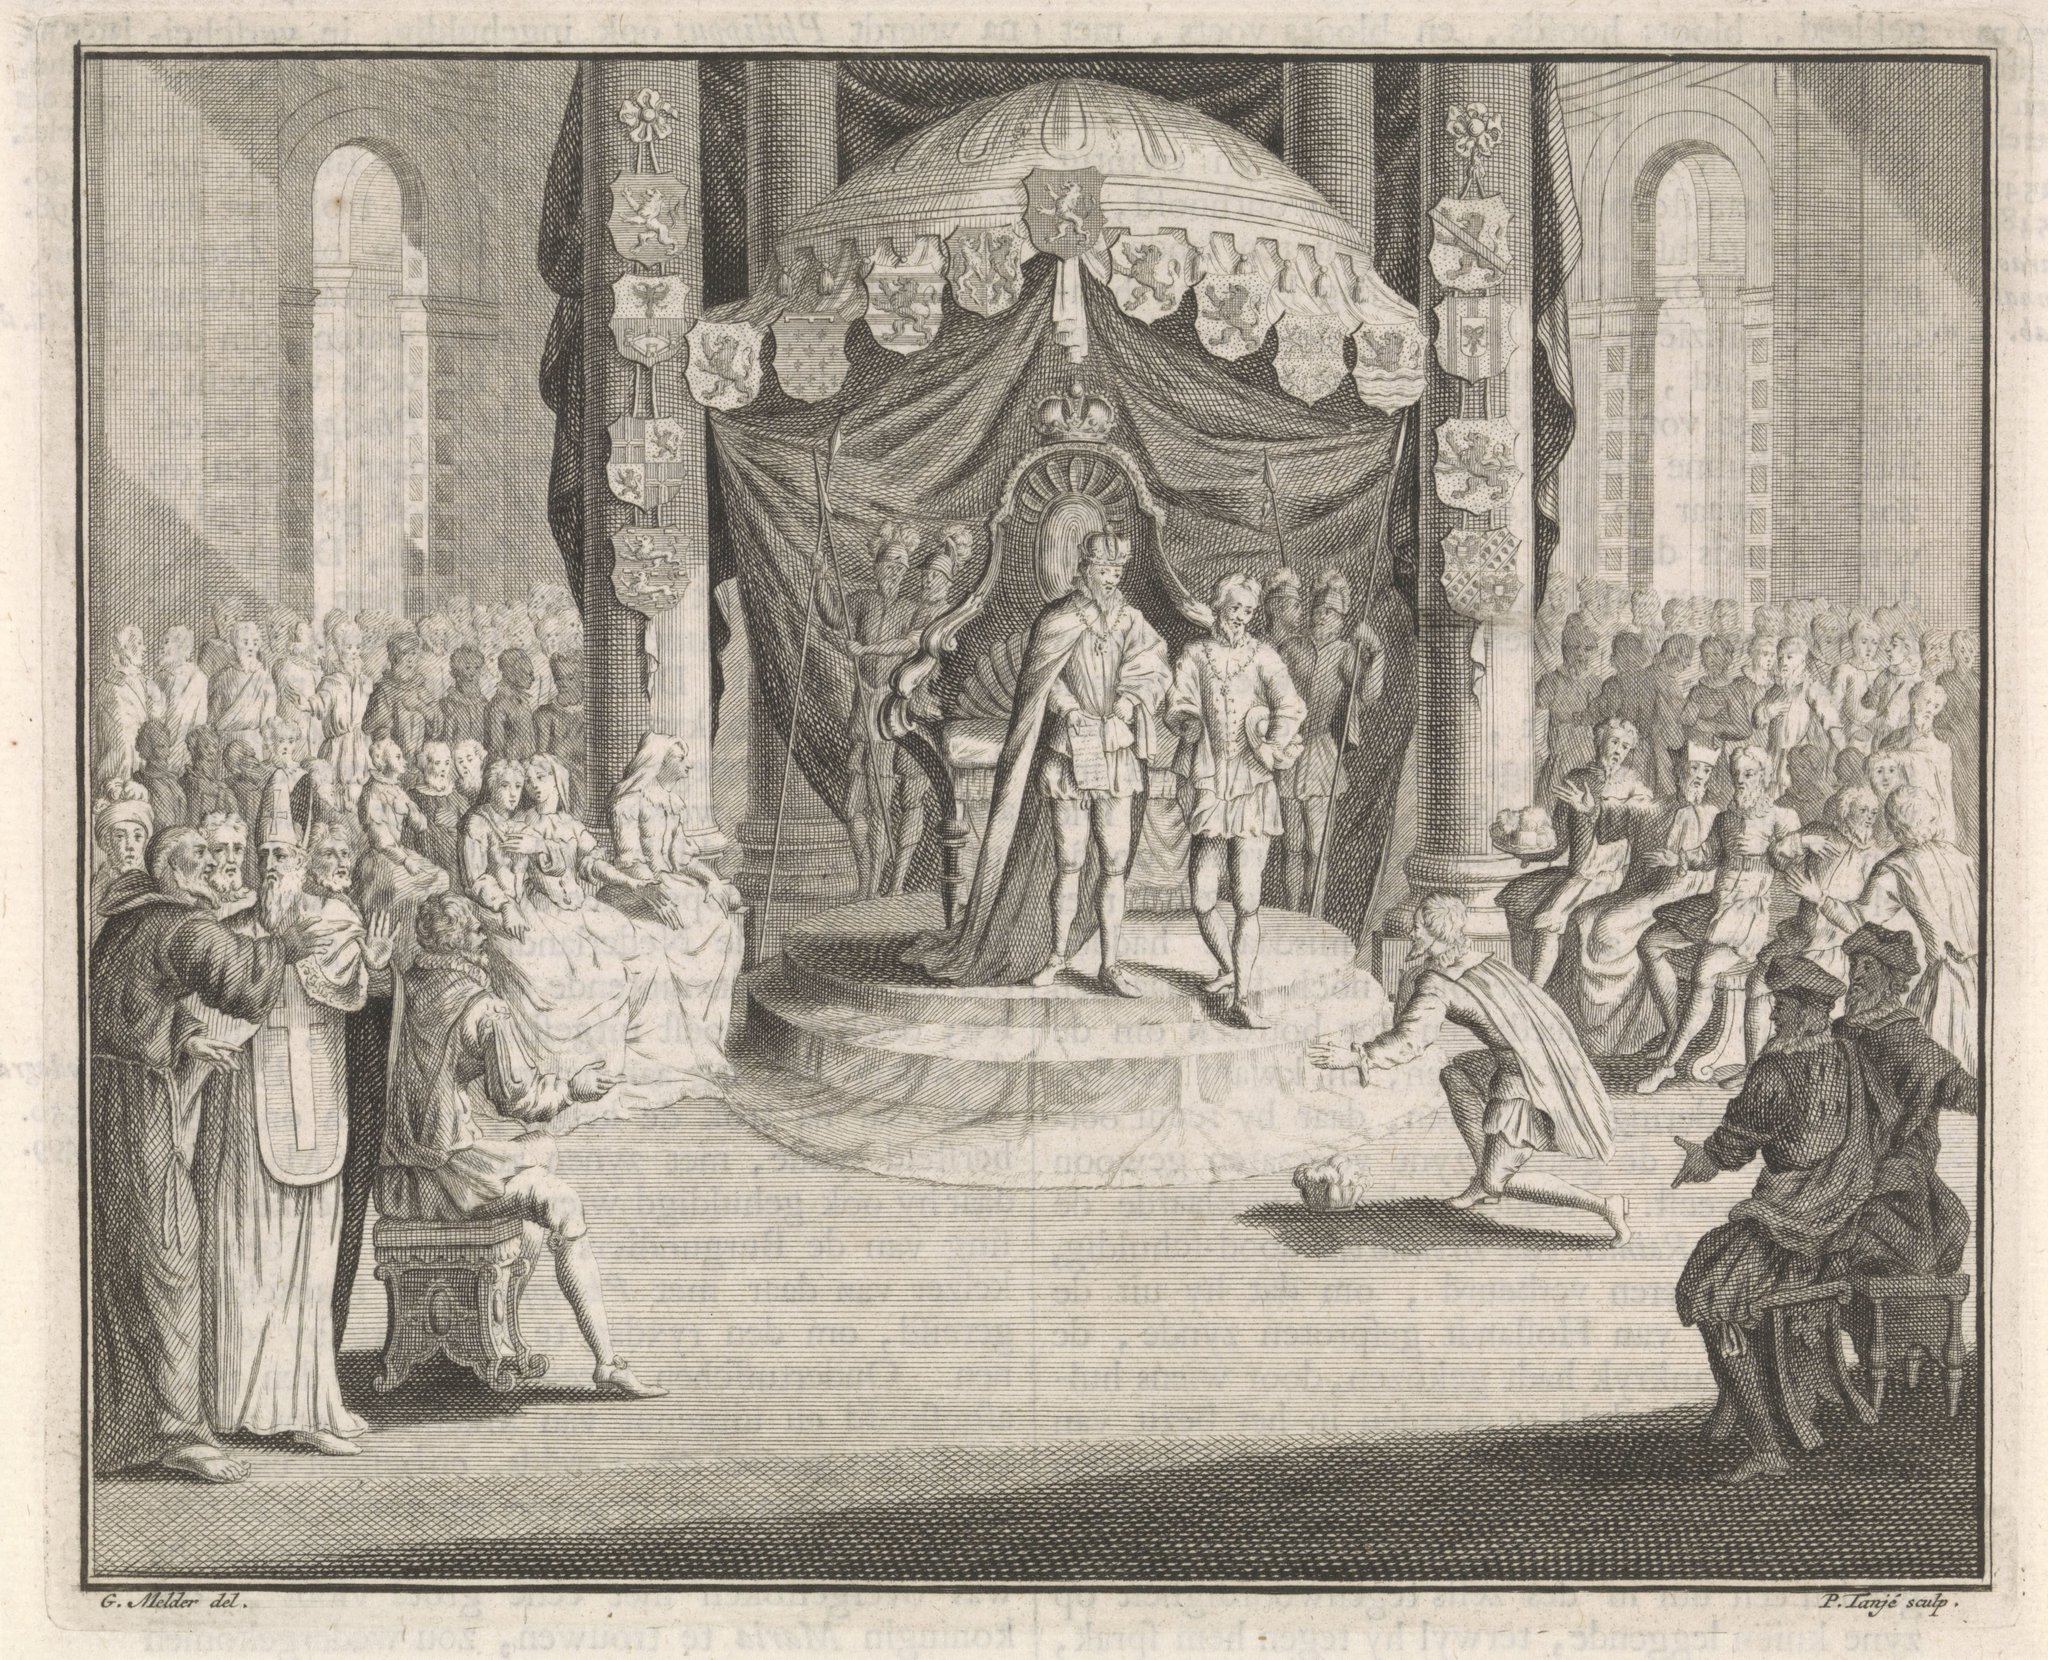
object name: book illustration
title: Keizer Karel V draagt het bestuur van de Nederlanden over aan Filips II van Spanje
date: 1716-1761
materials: paper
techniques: engraving, etching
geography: amsterdam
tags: philip ii of spain, ghent, charles v (holy roman emperor and king of spain), ruler, sovereign, kneeling figure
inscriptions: collector's mark: Lugt 2228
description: Keizer Karel V, staande onder een baldakijn met wapenschilden, draagt op 25 oktober 1555 het bestuur van Nederland over aan zijn zoon Filips II.